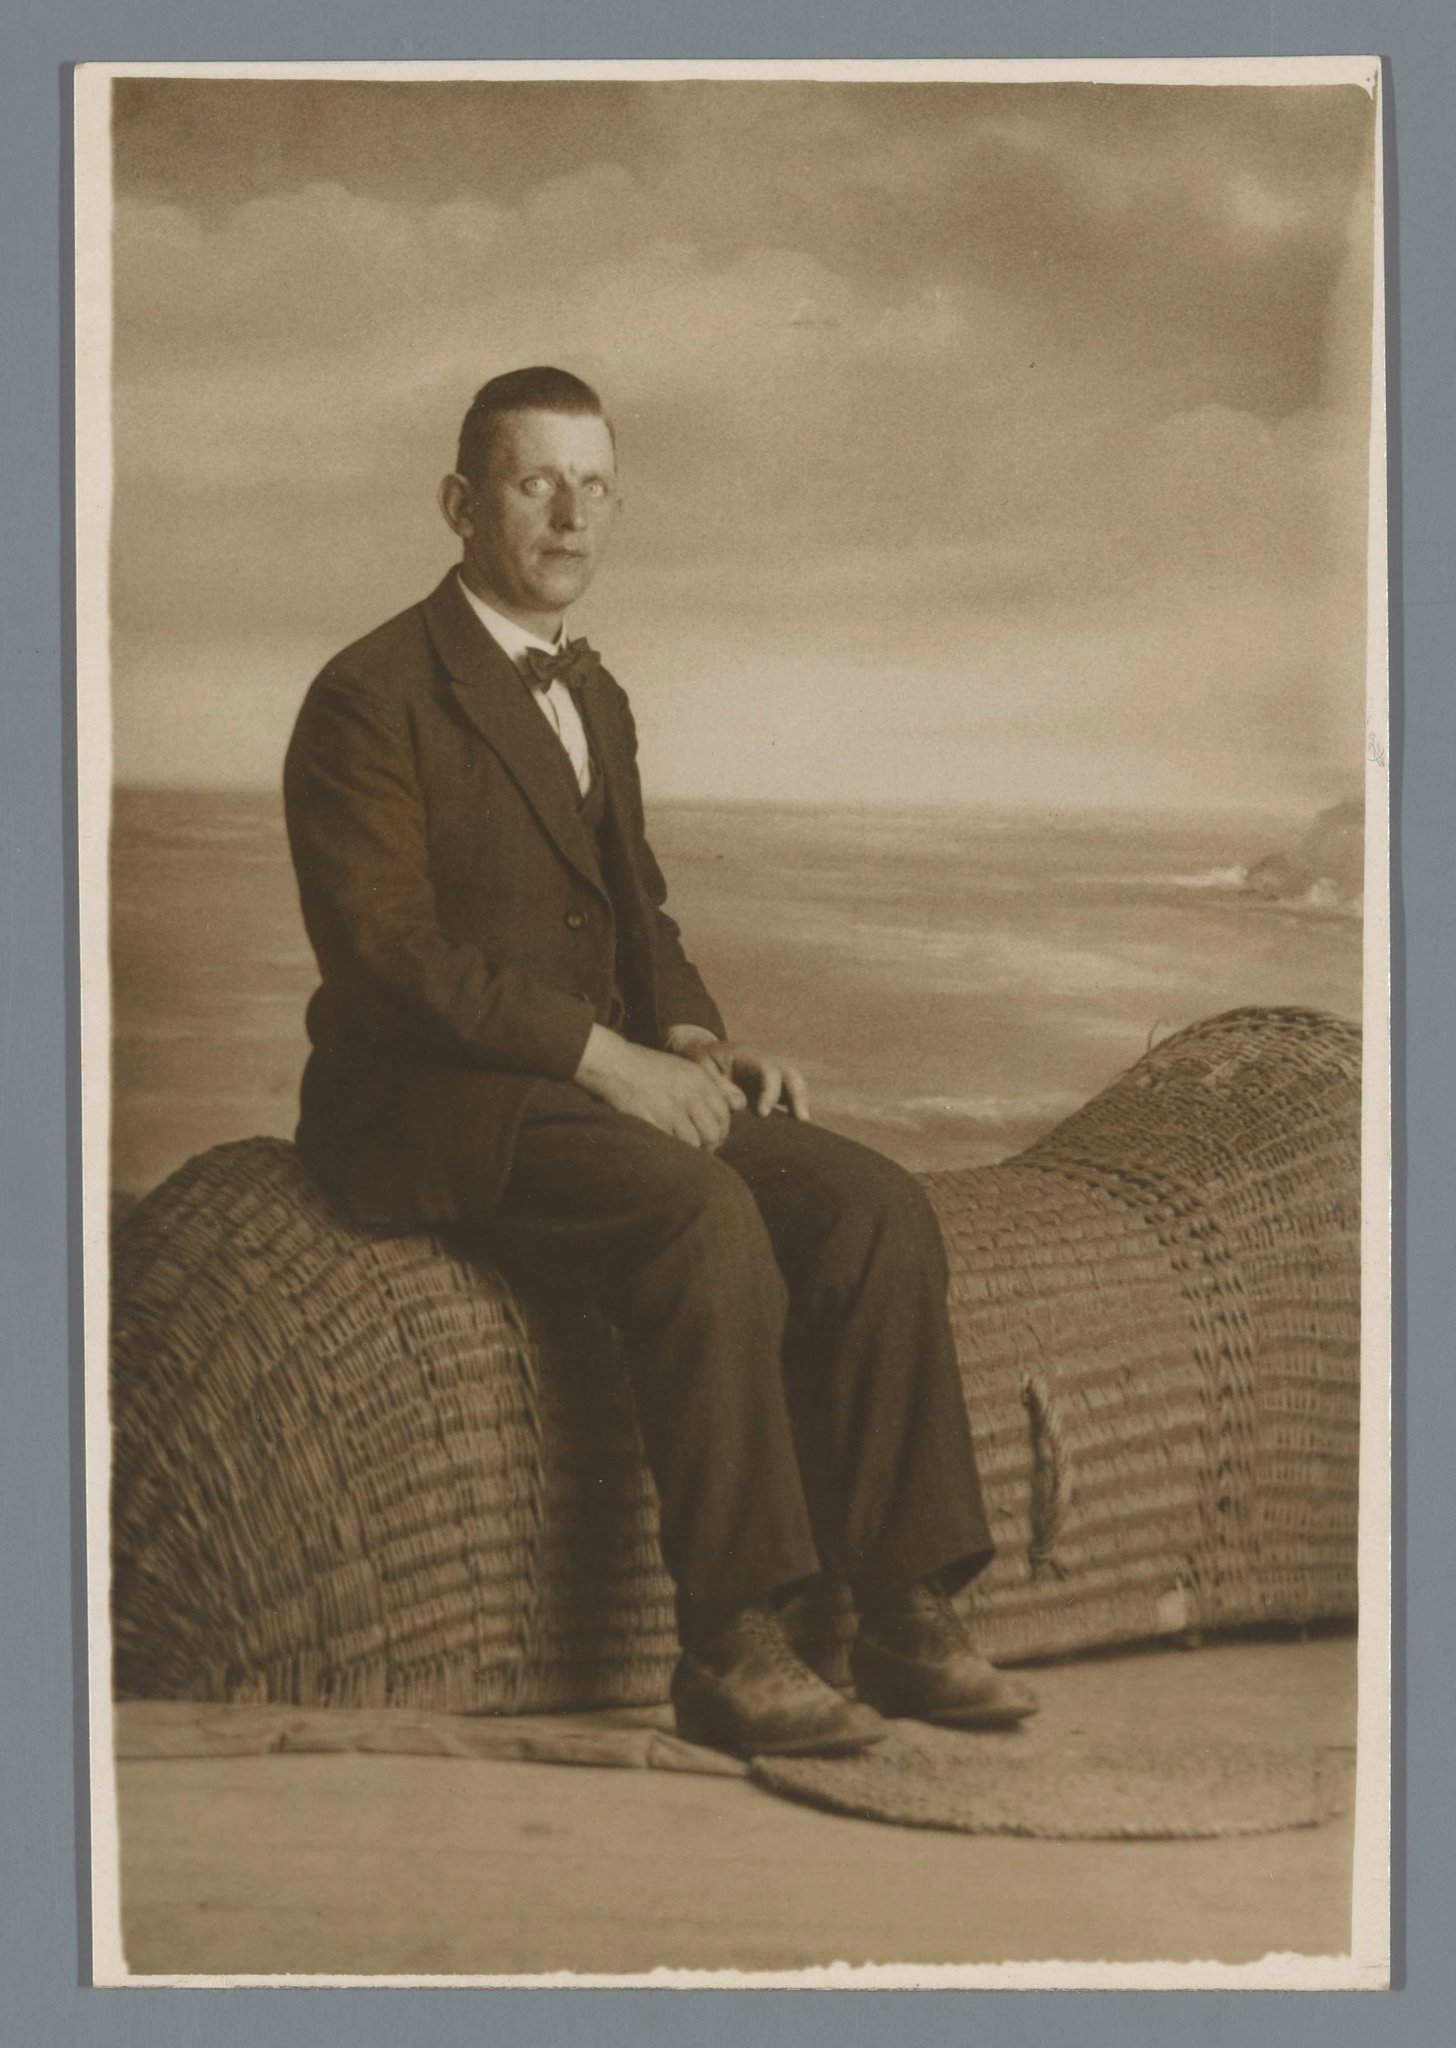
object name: ansichtkaart, prentbriefkaart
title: Studioportret van een onbekende man op een rieten strandstoel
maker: Anonymous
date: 1907-1920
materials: photographic support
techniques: gelatin silver print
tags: studio ~ photographer, adult man, chair